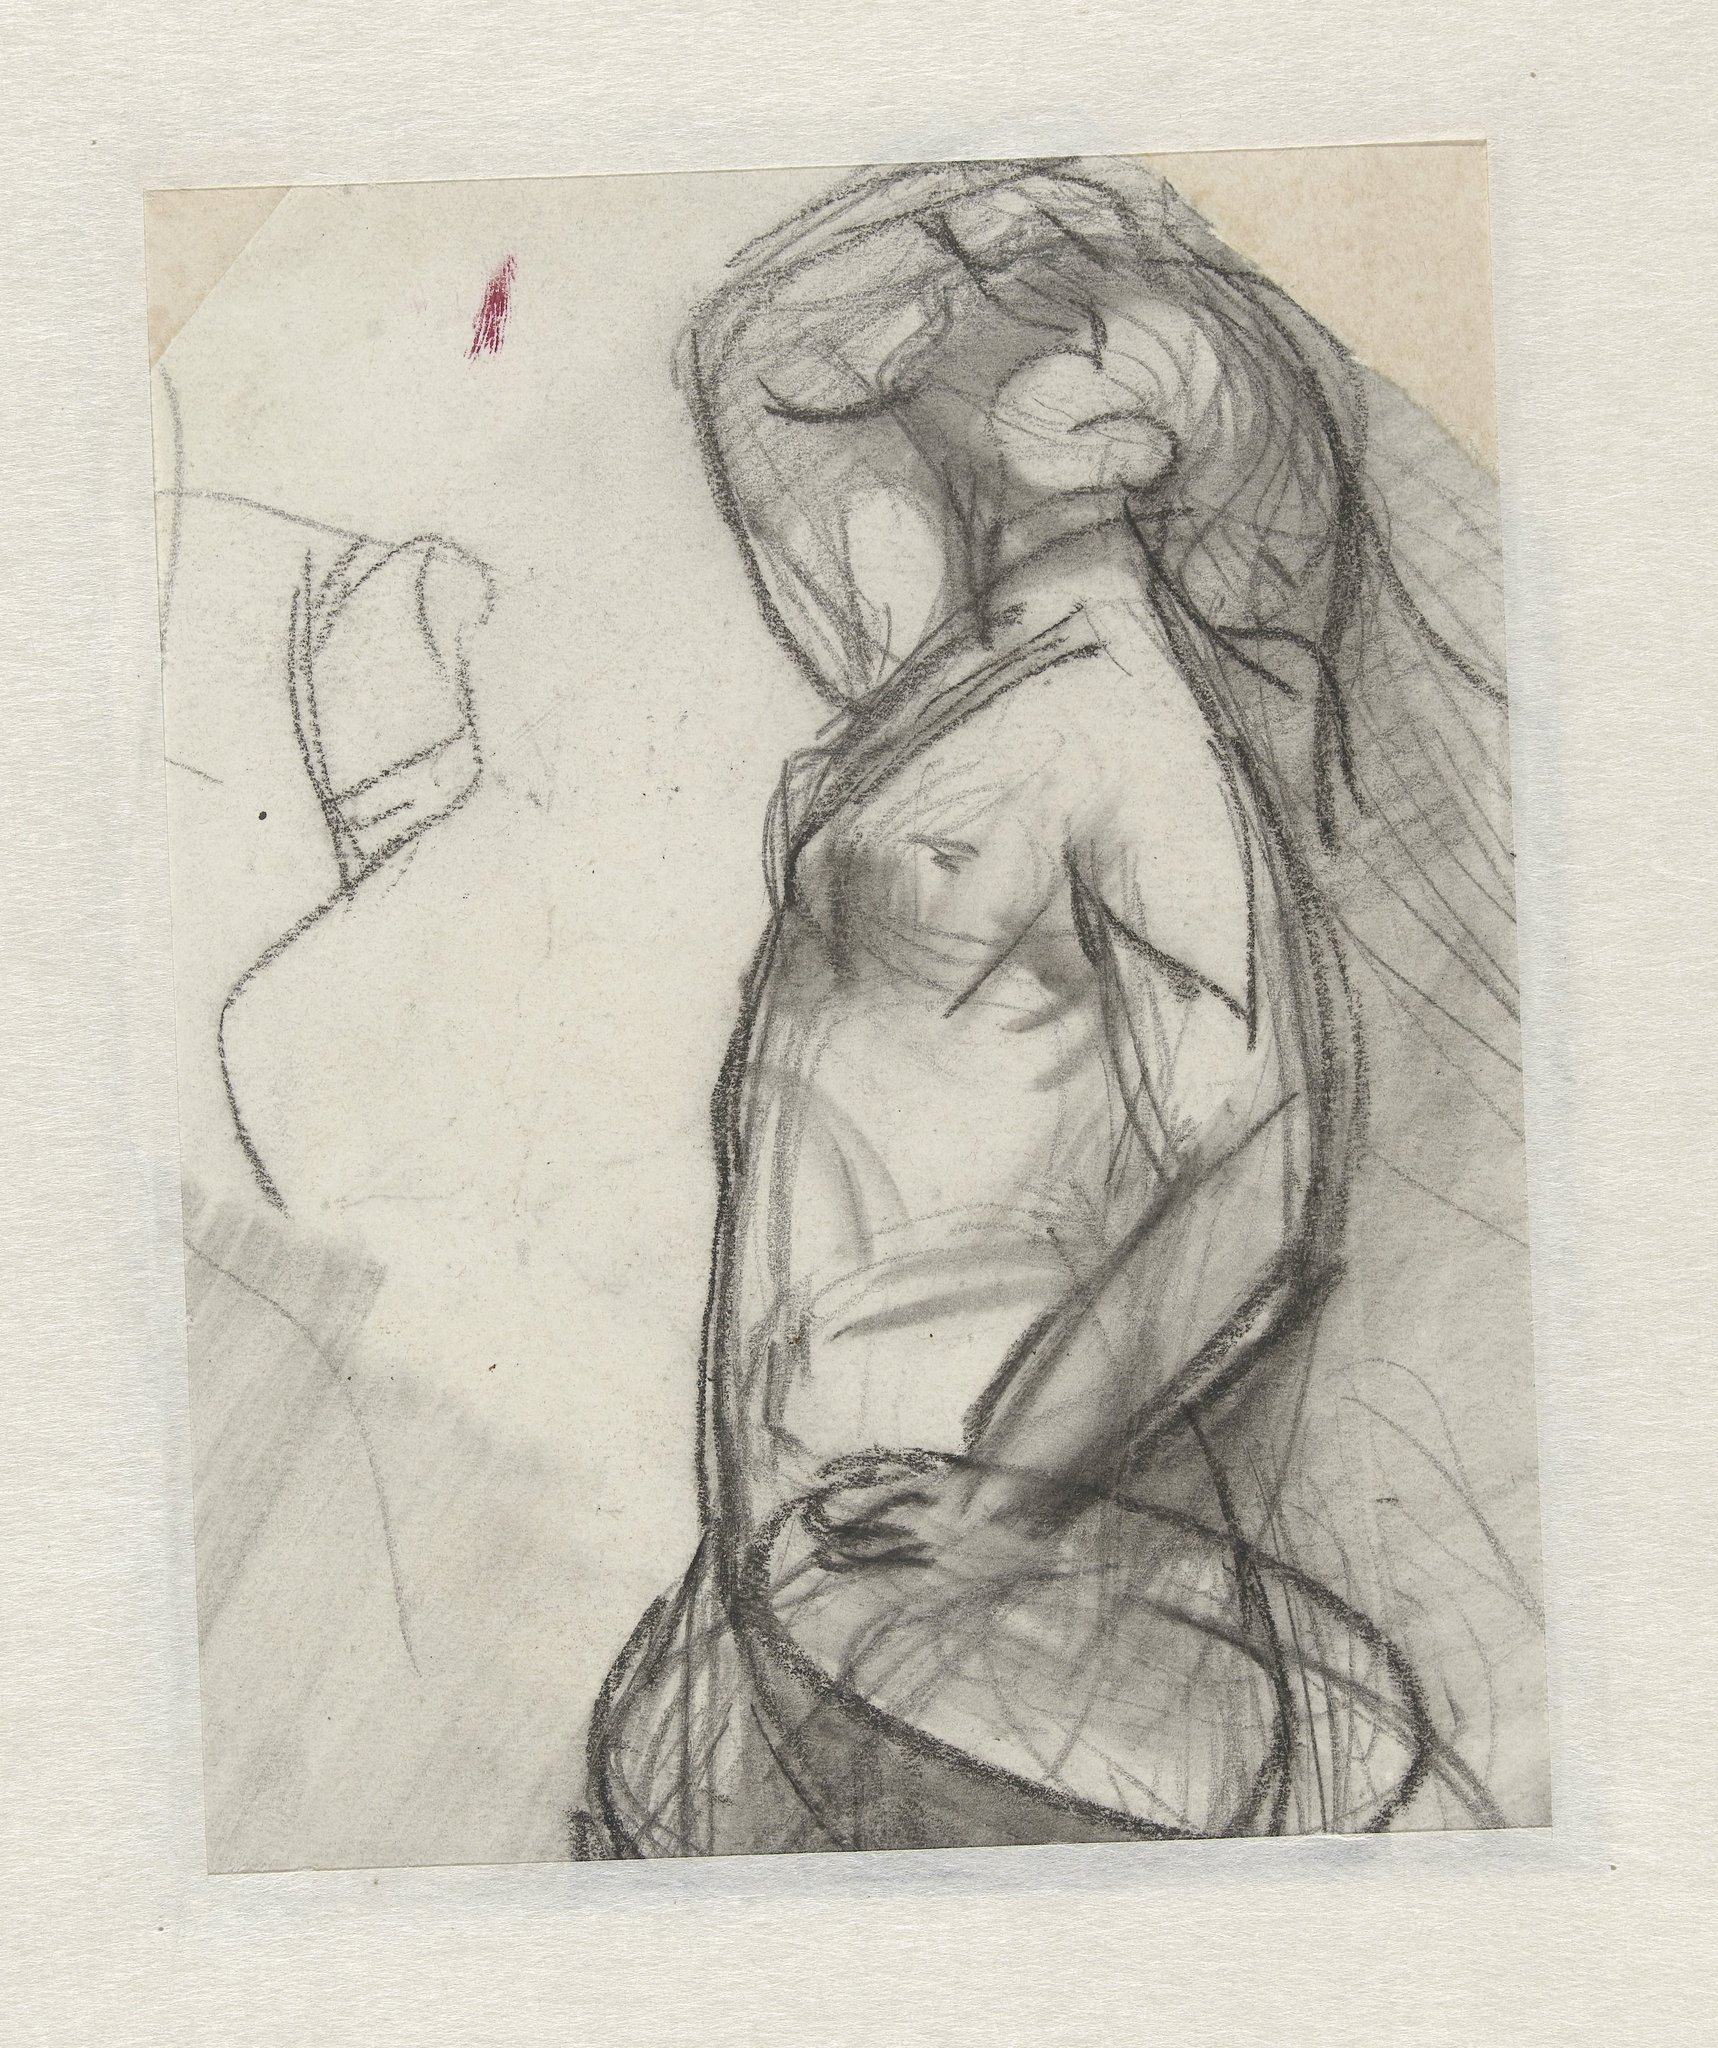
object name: drawing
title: Staand vrouwelijk naakt, omhoog kijkend met de hand boven de ogen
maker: august allebé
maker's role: draughtsman, print maker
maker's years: 1838-1927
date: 1848-1927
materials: chalk, paper